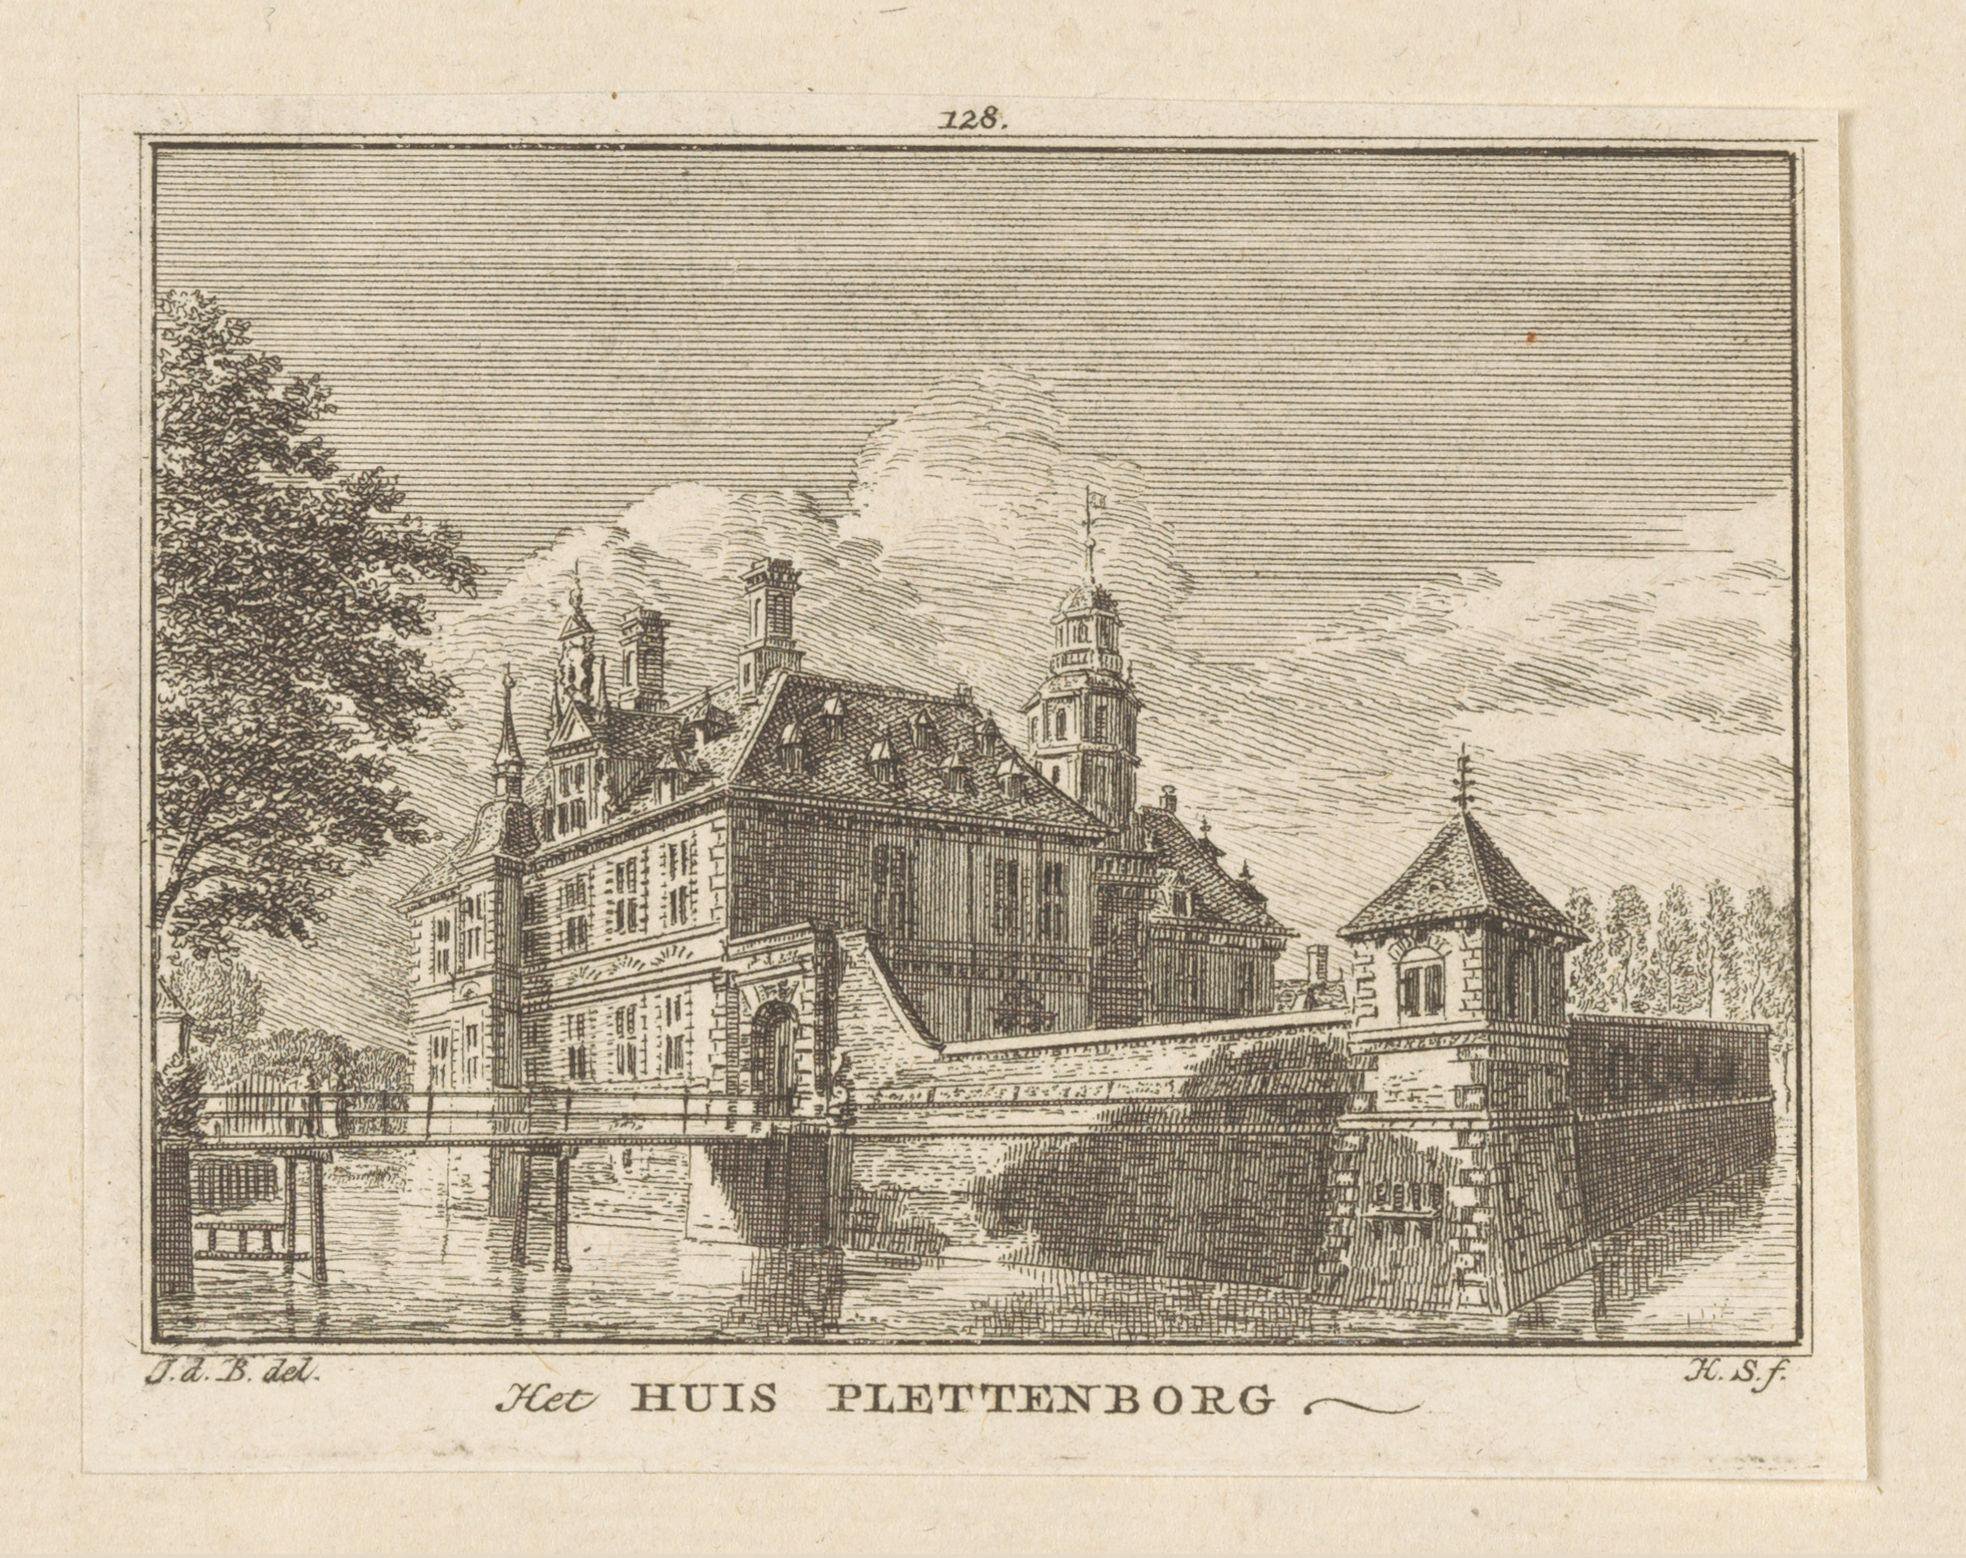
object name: book illustration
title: Het huis Plettenborg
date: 1773-1792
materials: paper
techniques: engraving, etching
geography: haarlem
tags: castle, bridge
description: Prent ook gebruikt in: Het verheerlykt Nederland of kabinet van hedendaagsche gezigten van steden, dorpen (…). 9 delen. Amsterdam: Isaak Tirion en weduwe Isaak Tirion, 1745-1774, dl. 7, 8 of 9 (weduwe Isaak Tirion, 1773-1774), ill. 128. Of in: Nederlandsche tafereelen; of eene keurige verzameling van negen honderd fraaije gezigten van steden, dorpen, sloten, oudheden (….). 9 delen. Amsterdam: Jan de Groot, 1792, dl. 7, 8 of 9, ill. 128. Uit welke druk het huidige exemplaar precies komt is niet na te gaan.